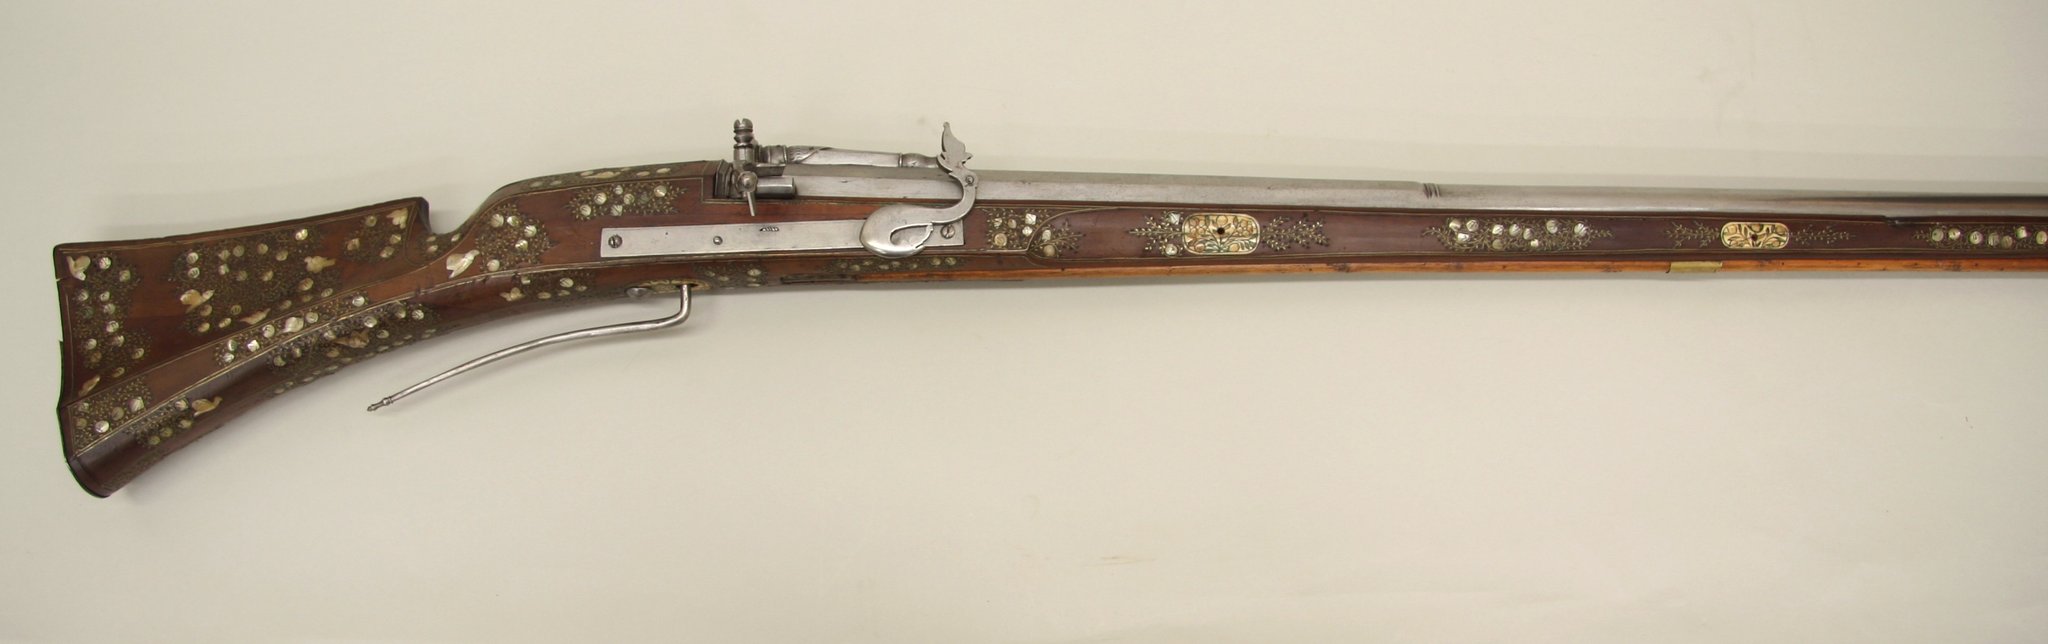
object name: matchlock gun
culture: german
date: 1501-1600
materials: bone, brass, mother of pearl, steel, wood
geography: germany